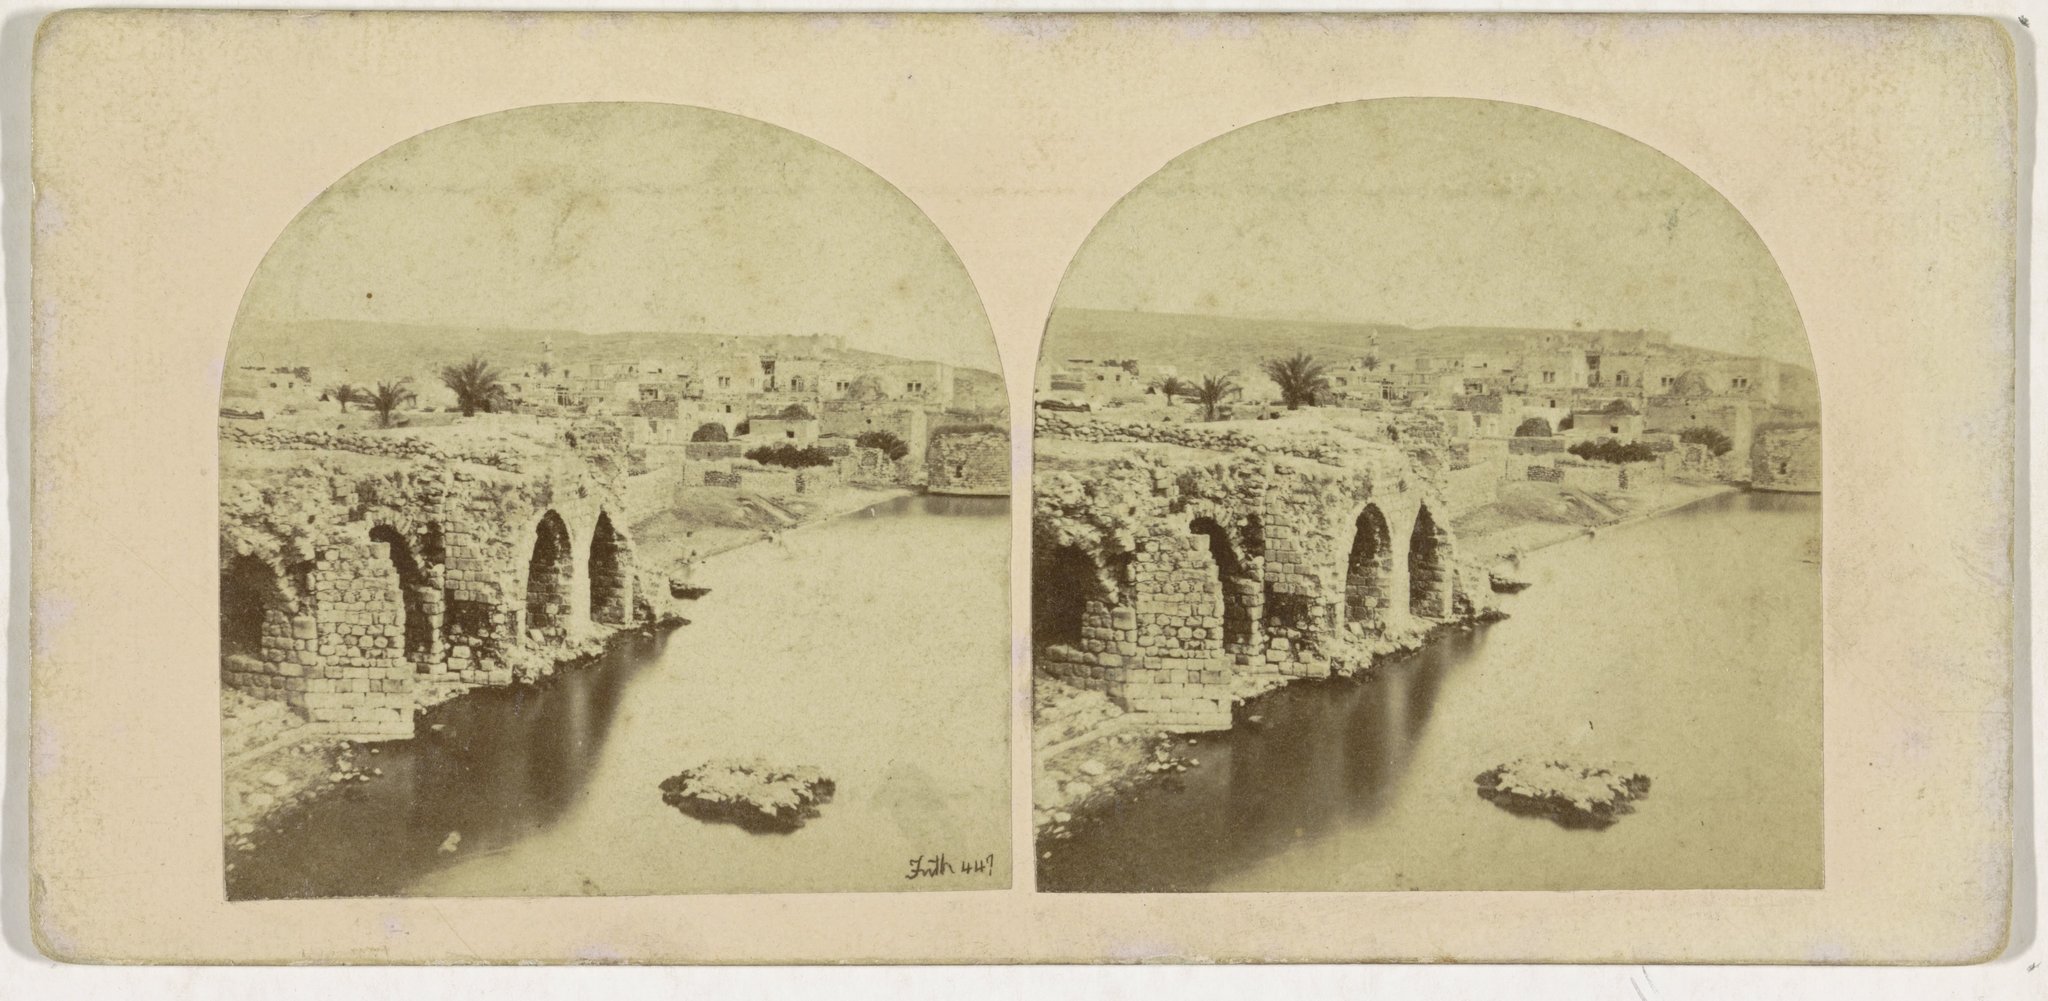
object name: stereograph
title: Gezicht op Tiberias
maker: francis frith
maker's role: publisher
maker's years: 1822-1898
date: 1856-1860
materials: cardboard, paper, photographic support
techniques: albumen print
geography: great britain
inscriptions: inscription: ‘Frith 447’, inscription: ‘448. / VIEWS IN THE HOLY LAND. / Tiberias, / Seen from the south, on the shore of the lake, looking in a north-west direction toward the / Mount of Magdala, on the distant horizon. / [...] / Entered at Stationer's Hall.] / [Deposé.’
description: Gezicht op Tiberias met op de voorgrond water.